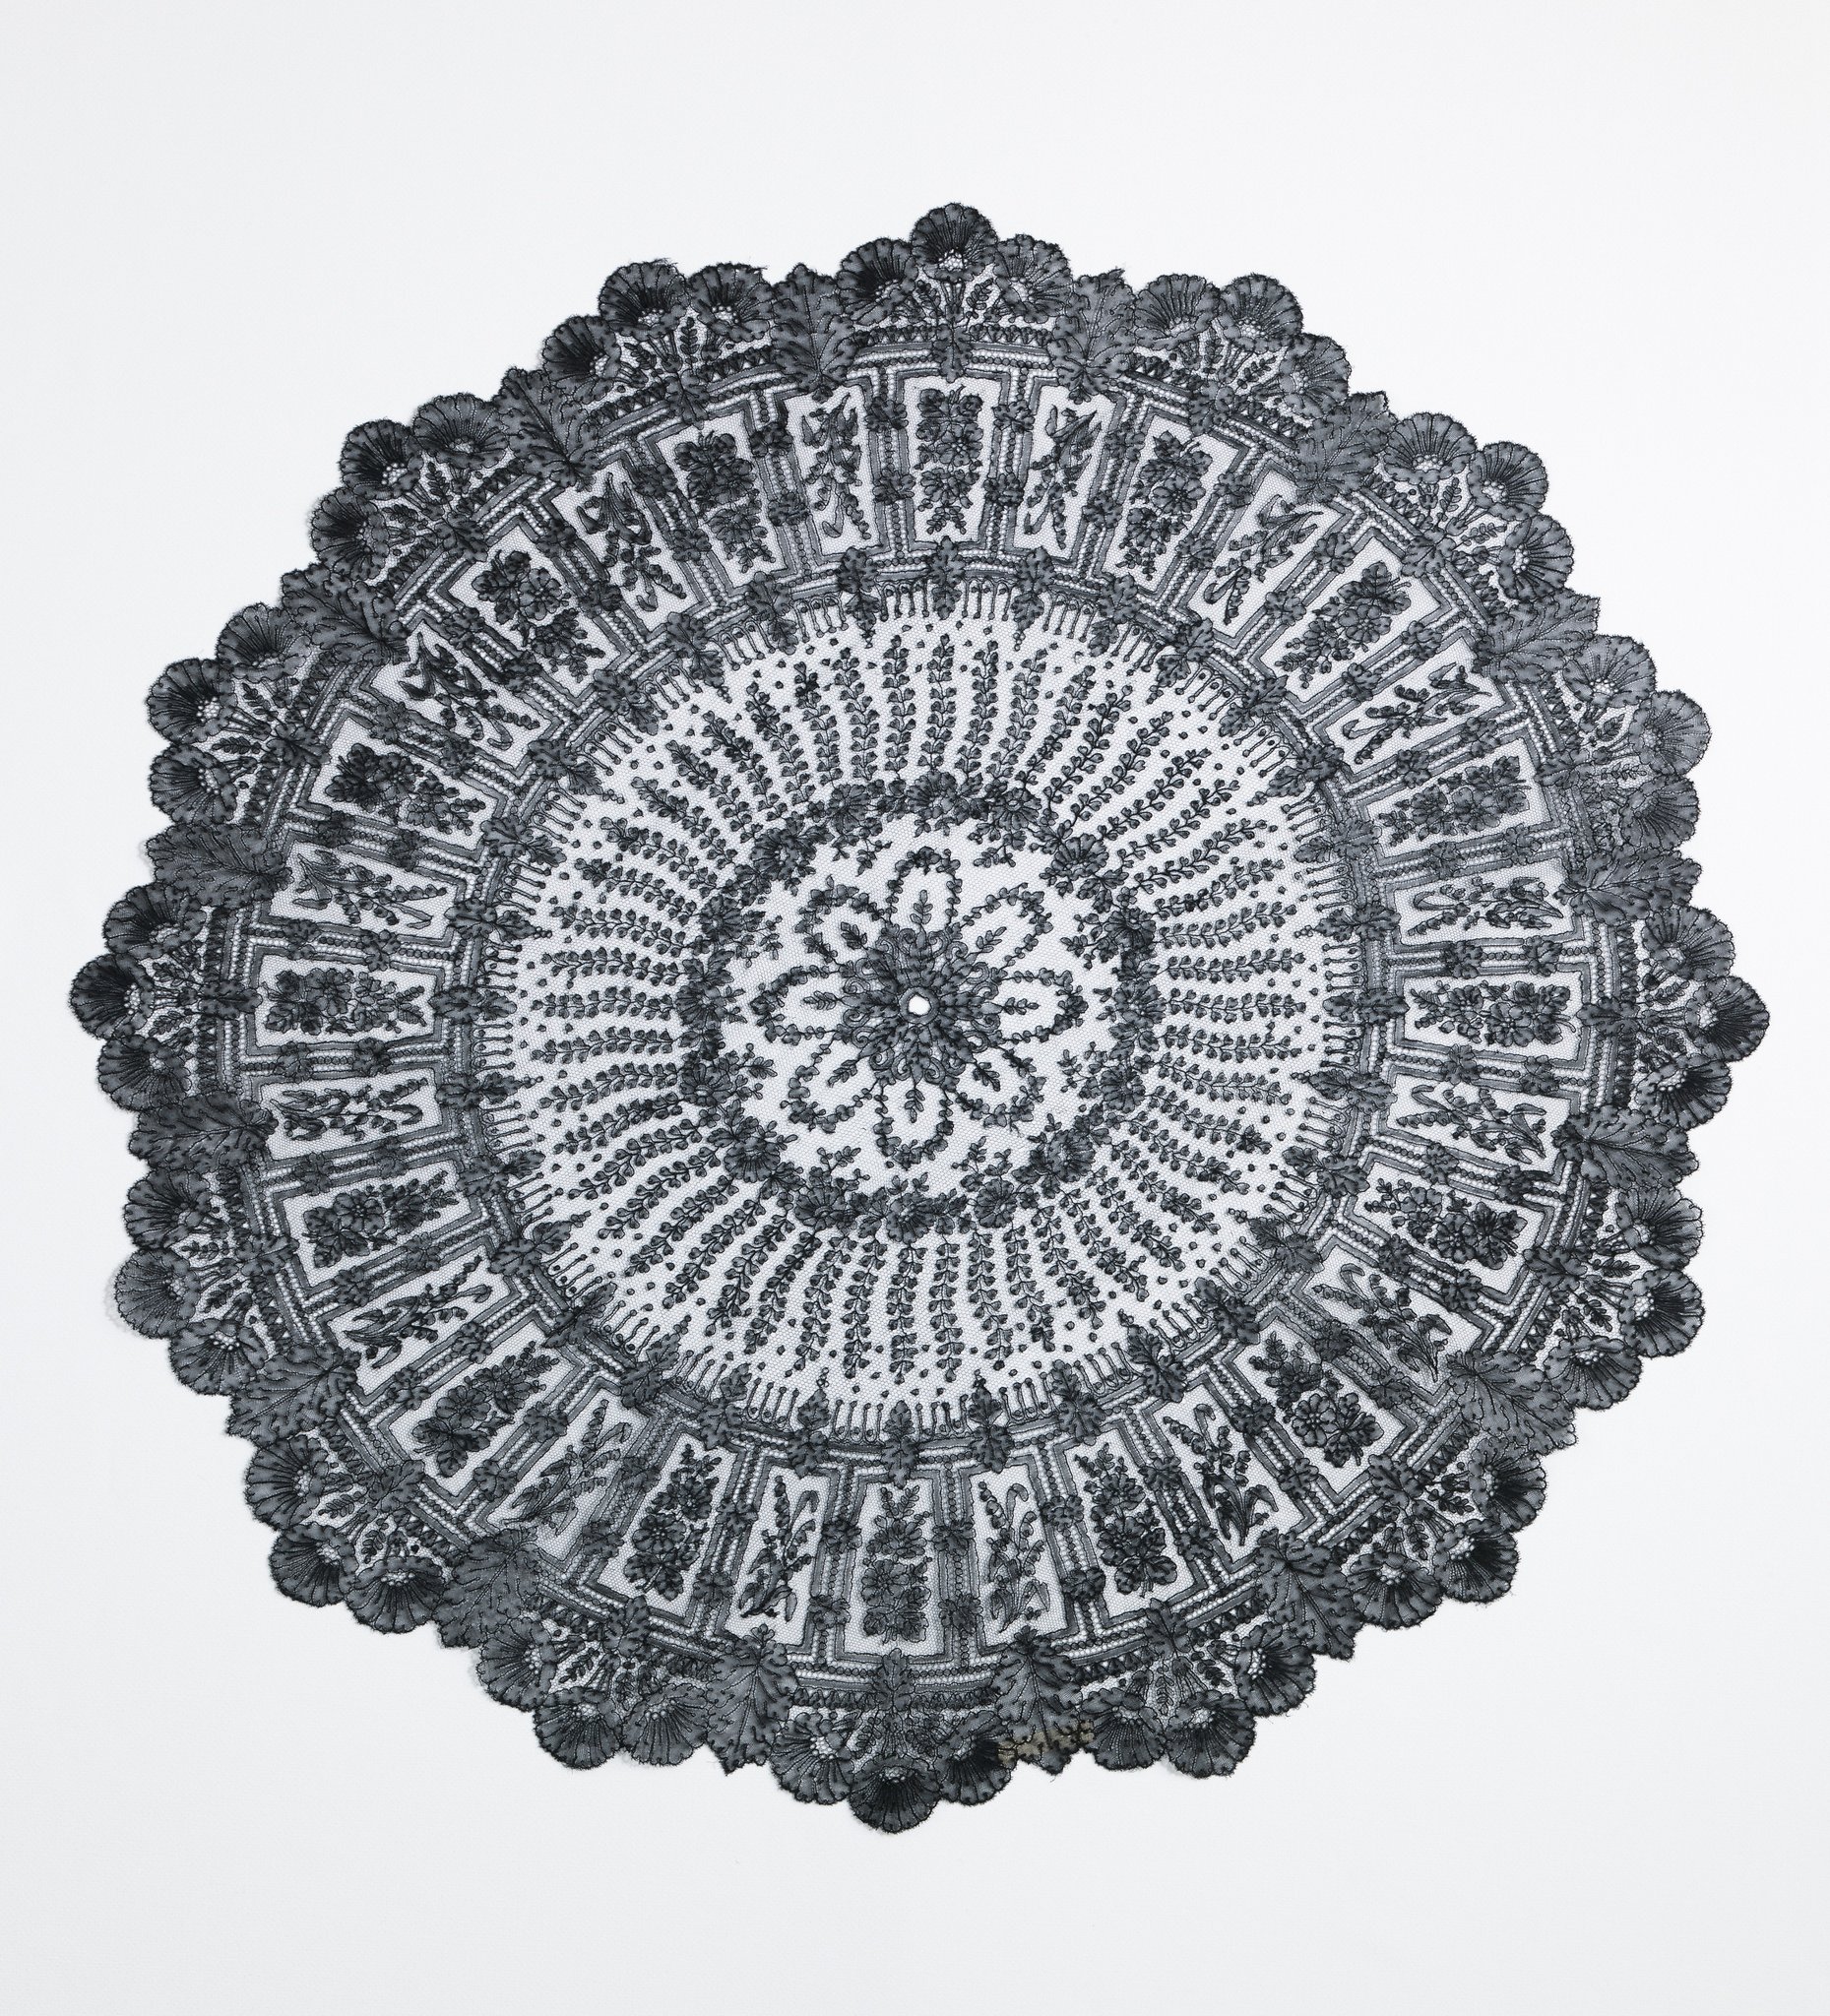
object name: parasol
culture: french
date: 1876-1900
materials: silk